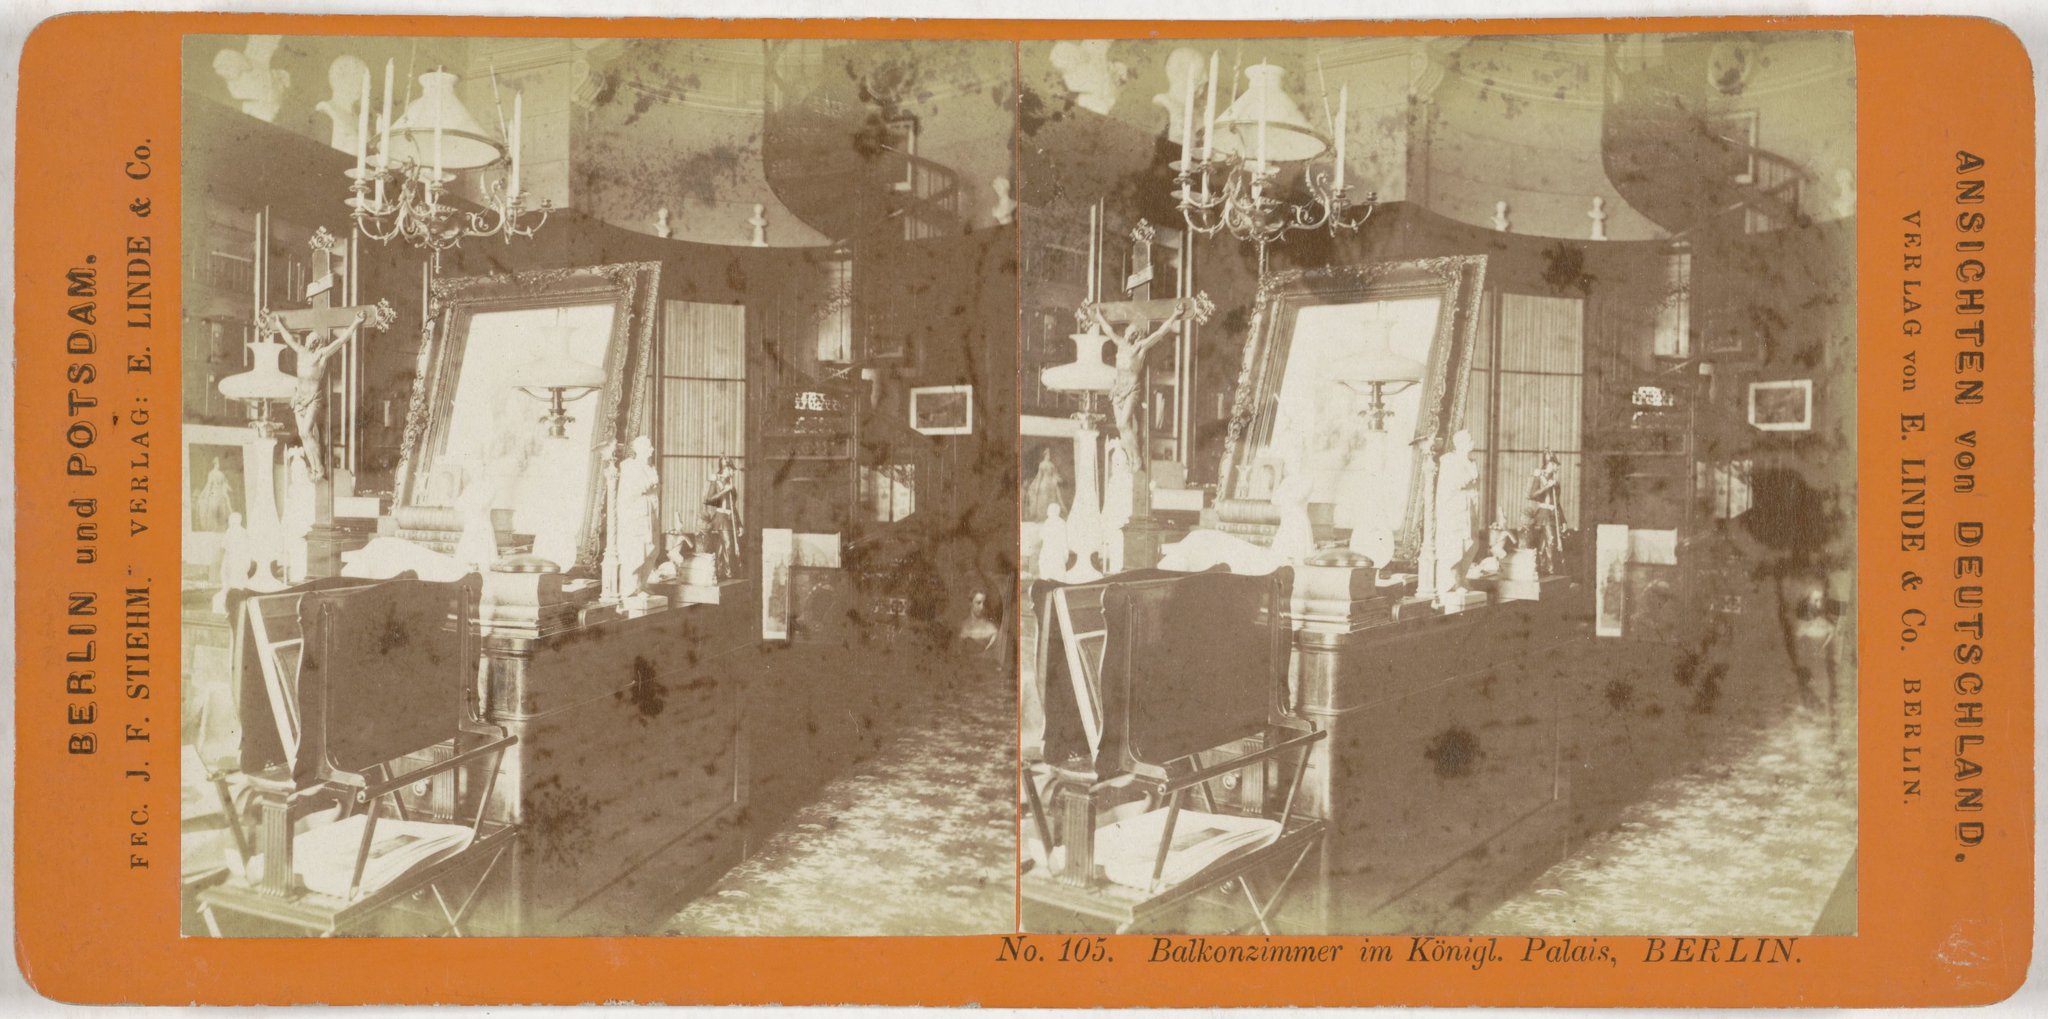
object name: stereograph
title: Balkonzimmer im Königl. Palais, Berlin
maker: johann friedrich stiehm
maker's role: fotograaf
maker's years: 1826-1902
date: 1868-1870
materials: cardboard, paper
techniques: albumen print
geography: berlin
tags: palace, berlin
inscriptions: number: ‘No. 105’